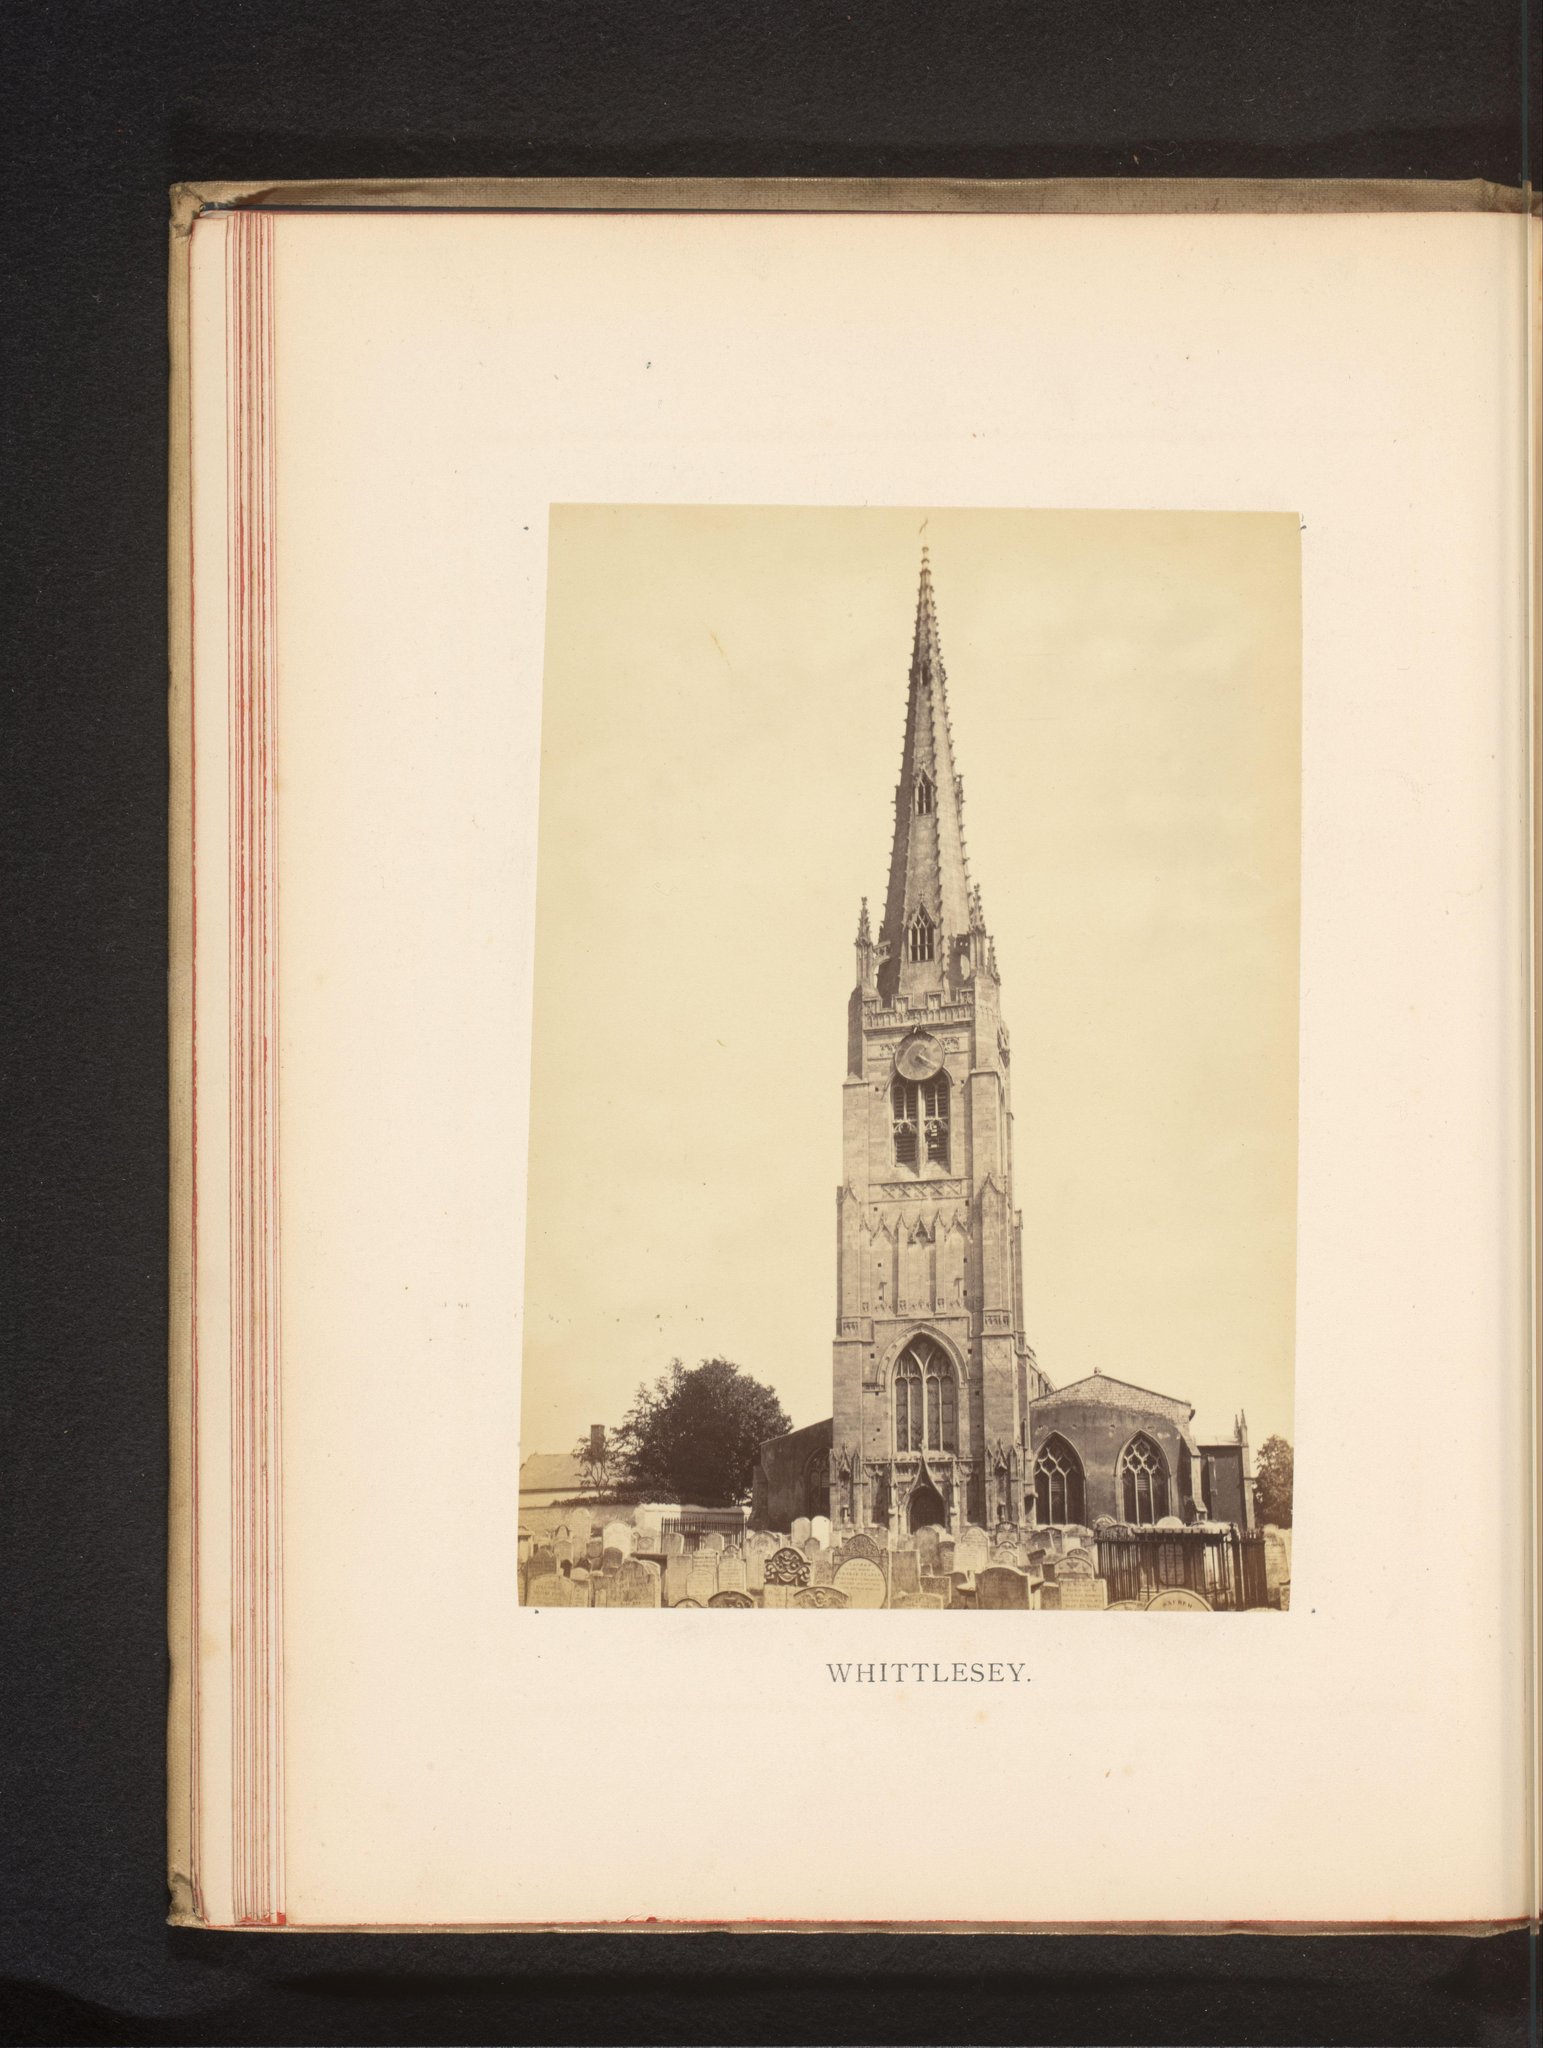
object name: photograph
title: Whittlesey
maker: Anonymous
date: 1858-1869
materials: photographic support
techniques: albumen print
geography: whittlesey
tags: parts of church exterior and annexes: spire, façade (of house or building), churchyard (around church)